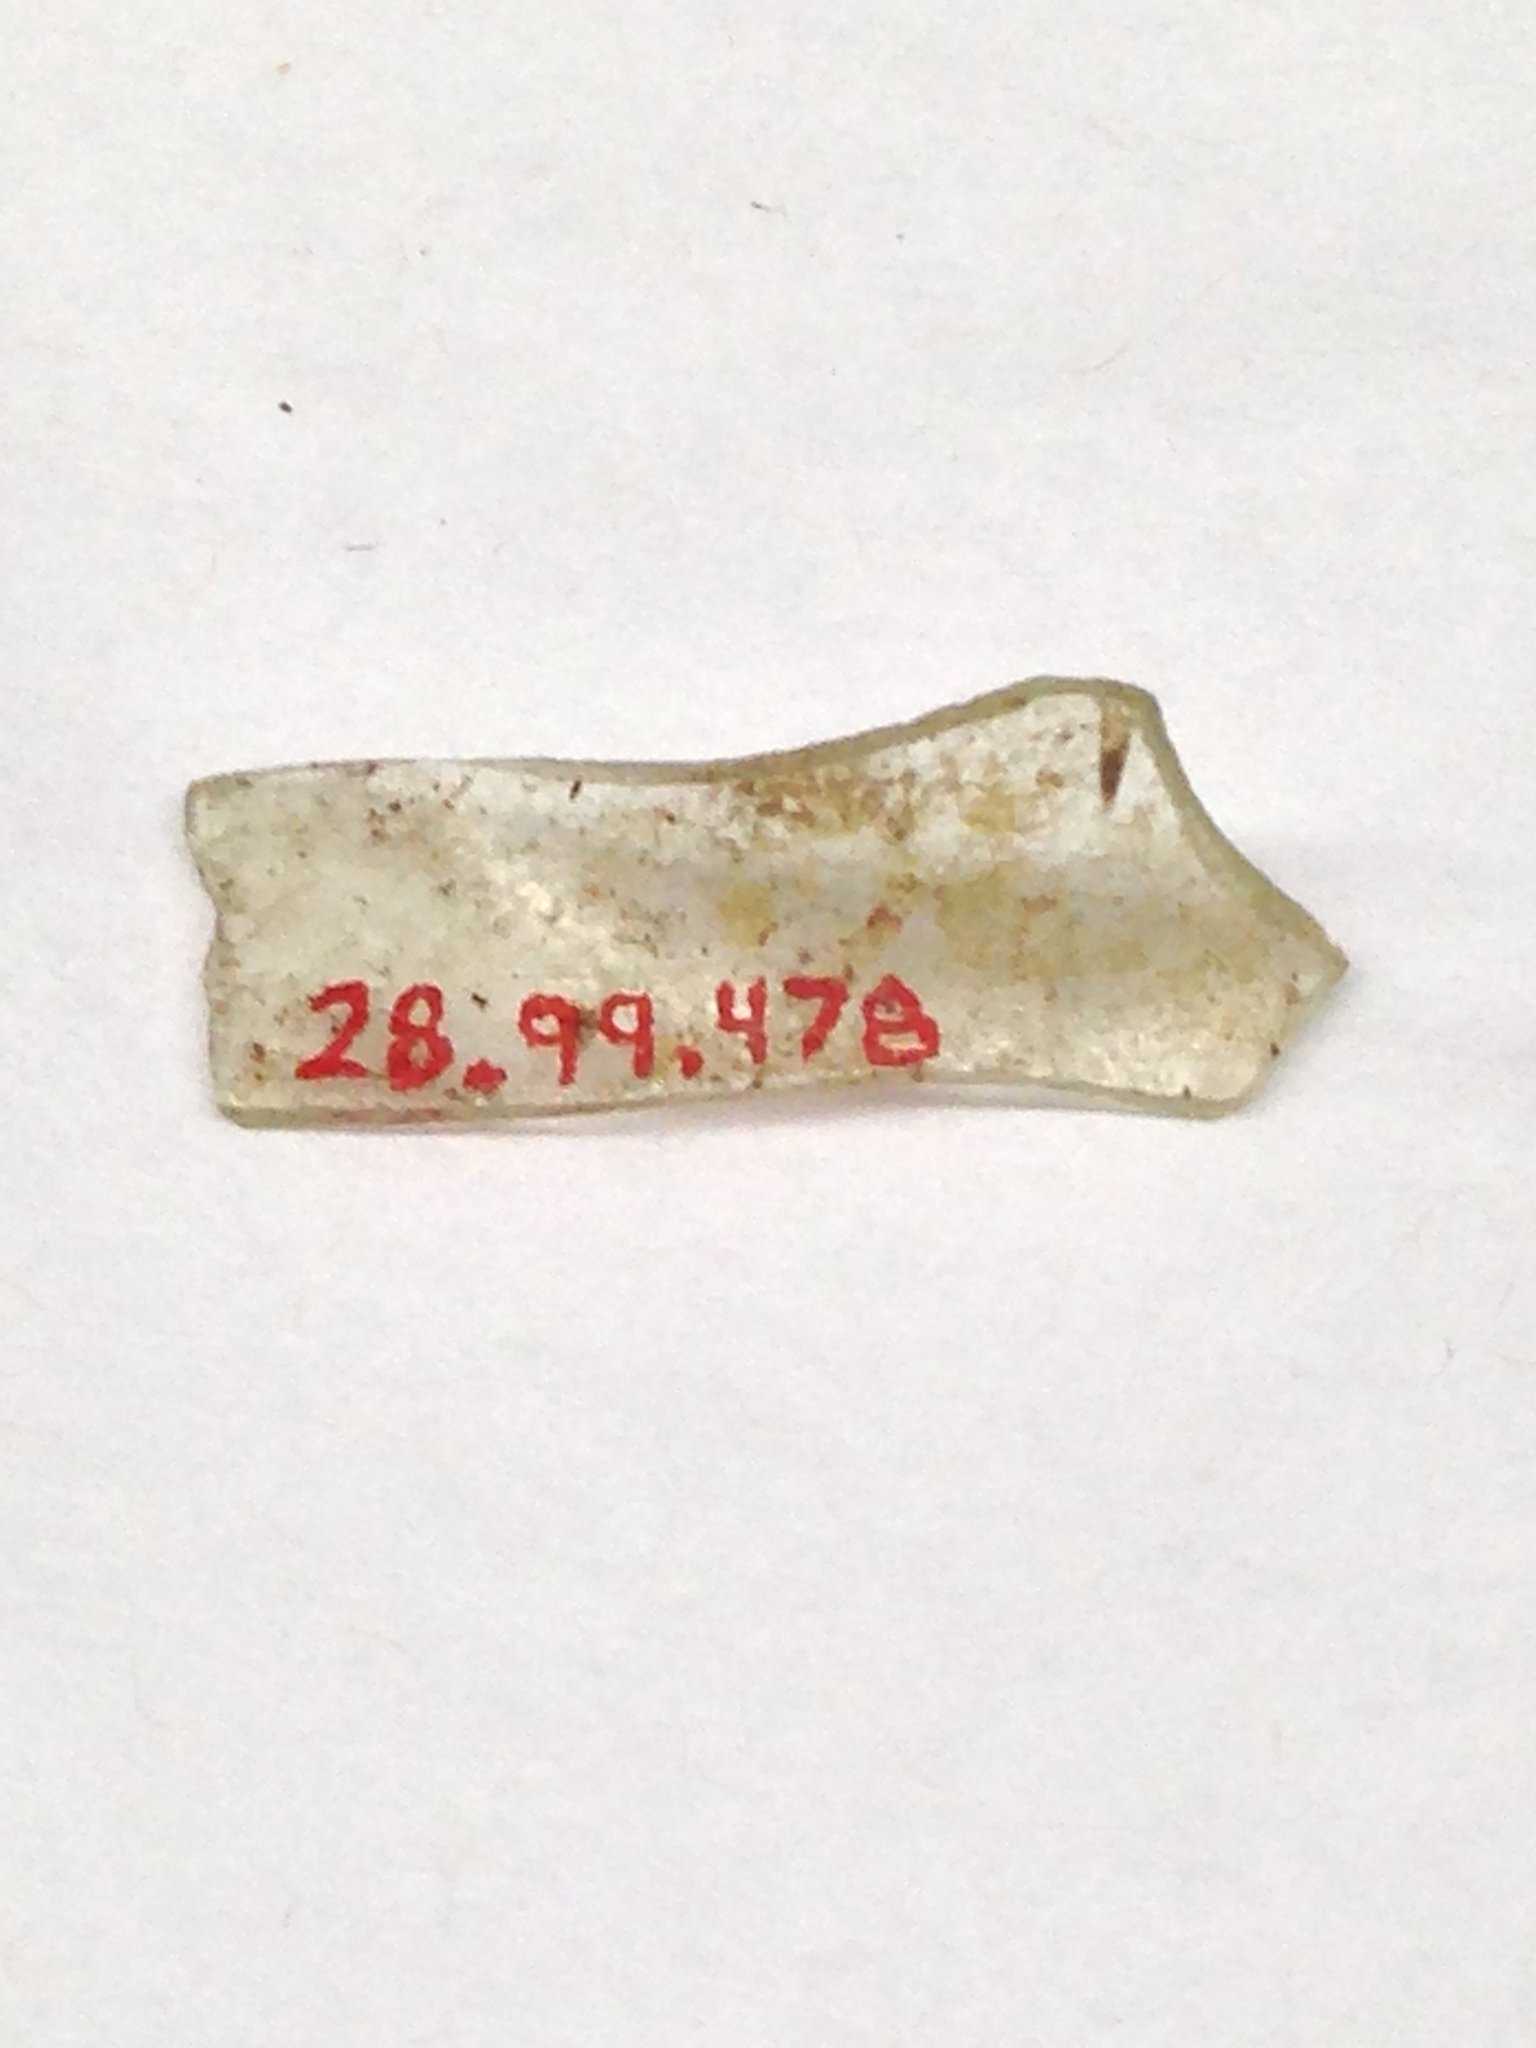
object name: fragment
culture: european or middle eastern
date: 1150-1250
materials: ceramic, glass